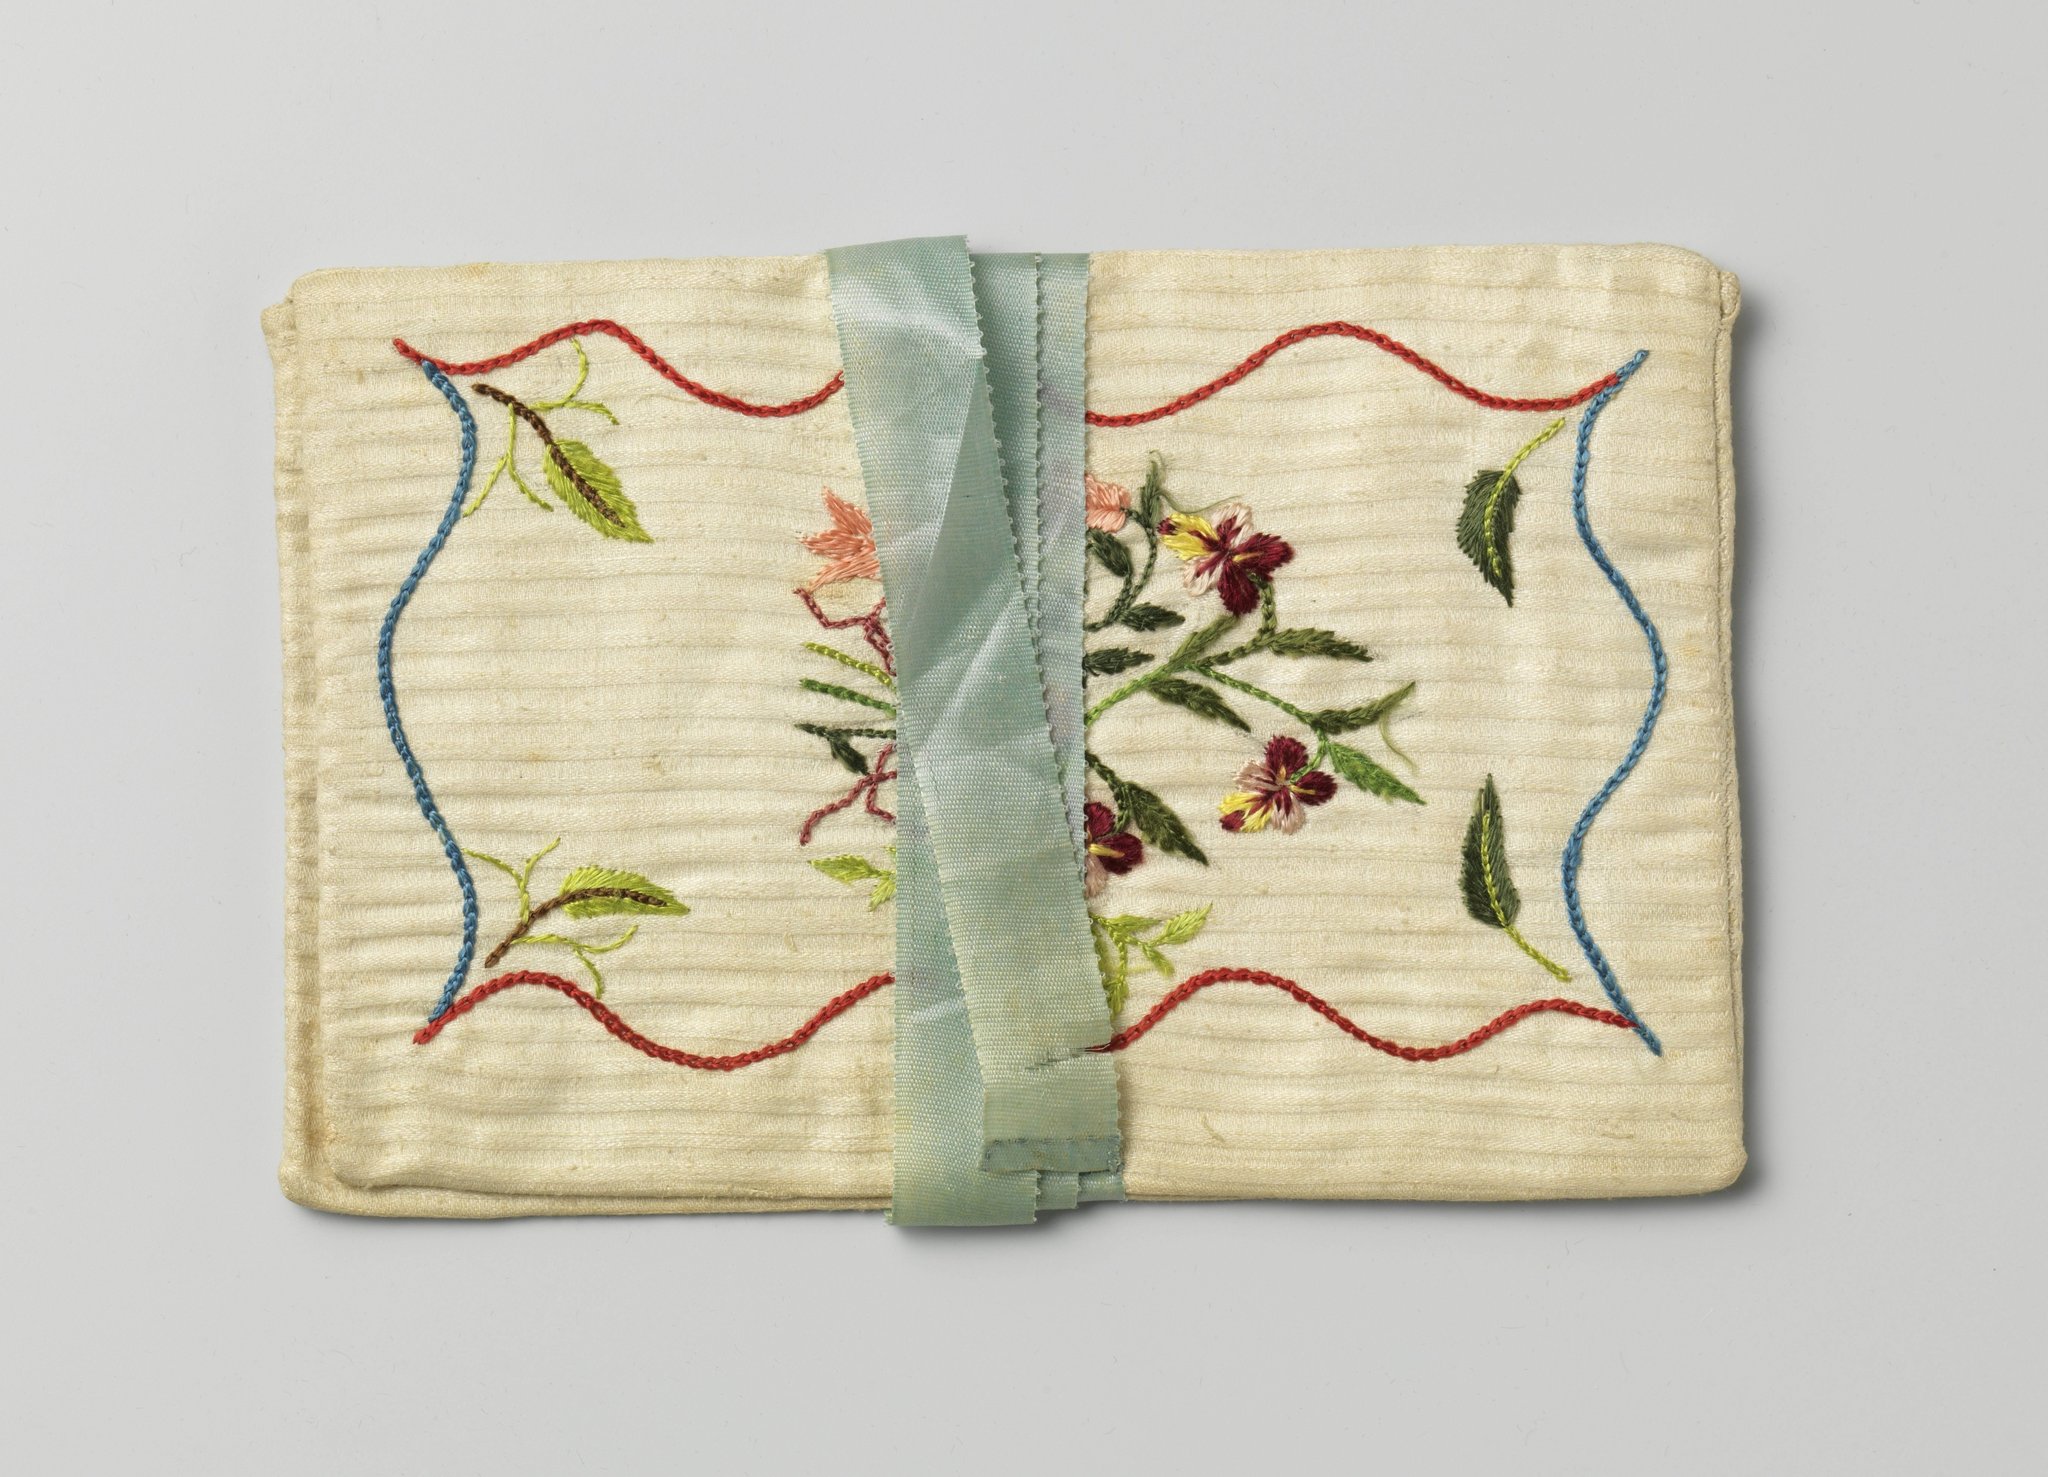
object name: étui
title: Brieventas in een plat, rechthoekig model, van witte katoen met ingeweven strepen, versierd met veelkleurig floraal zijden borduurwerk, met aan de binnenkant de initialen 'GMH', 'souvenir d'amitie' en '1799'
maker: Anonymous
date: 1799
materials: cotton, linen, silk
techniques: embroidered, weave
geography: france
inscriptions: initials: ‘'AJA' of 'A7A'’, initials: ‘GMH’, inscription: ‘'souvenir d'amitie'’, date: ‘1799’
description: Brieventas in een plat, rechthoekig model, van witte katoen met ingeweven strepen, versierd met veelkleurig floraal zijden borduurwerk. Aan een kant een boeket met violen en roze tulpen binnen een slingerende baan van rode en blauwe zijde, aan de andere kant vijf verschillende takken met bloemen, waarvan vier in de hoeken en een centraal in het midden. Binnenin twee geborduurde medaillons aan roze strikken en groene takken. In het linker medaillon de initialen 'GMH', in de rand van het rechter medaillon 'souvenir d'amitie' met in de cirkel 'AJA' en daaronder het jaartal '1799'. In het midden een opening naar twee rechthoekige vakken, die gevoerd zijn met wit glanzend linnen. De tas is dubbelgevouwen en omwonden met een blauwgrijs lint van synthetisch zijde.